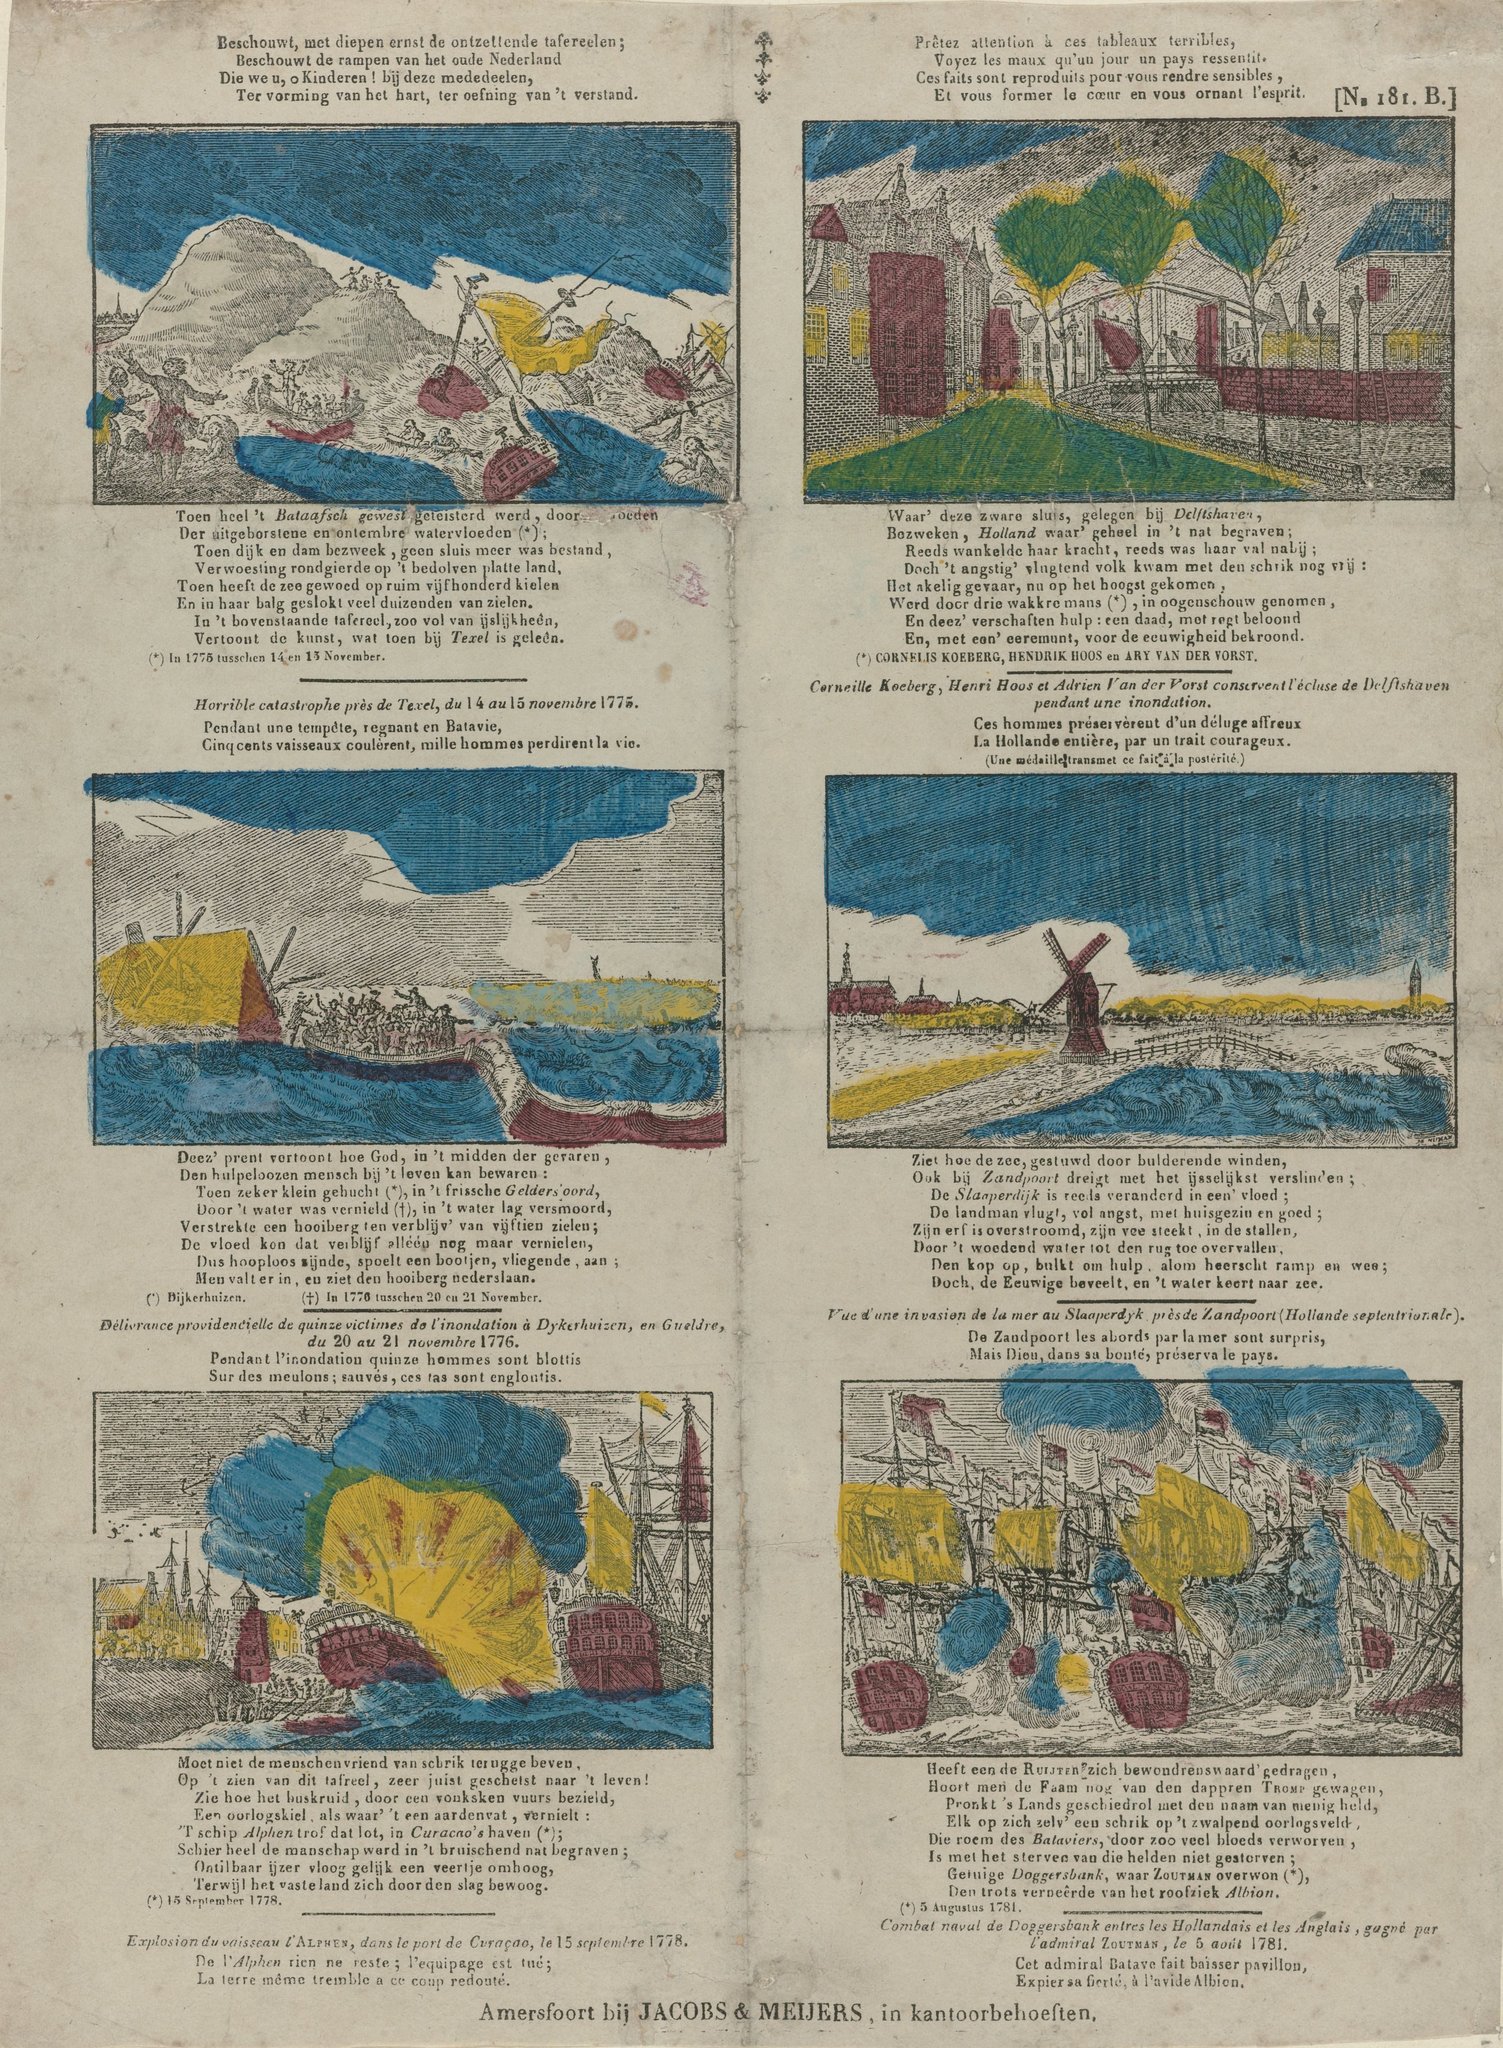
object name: print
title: Beschouwt, met diepen ernst de ontzettende tafereelen; / Beschouwt de rampen van het oude Nederland [(...)]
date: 1800-1833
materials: paper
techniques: colour, letterpress printing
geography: turnhout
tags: flood, gunpowder disaster, netherlands, delfshaven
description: Blad met 6 voorstellingen van grote rampen uit de nederlandse geschiedenis, waaronder de overstroming van Texel en ontploffing van een Nederlands schip in de haven van Curacao. Onder elke afbeelding een onderschrift in het Nederlands en in het Frans. Genummerd rechtsboven: [N. 181. B.].